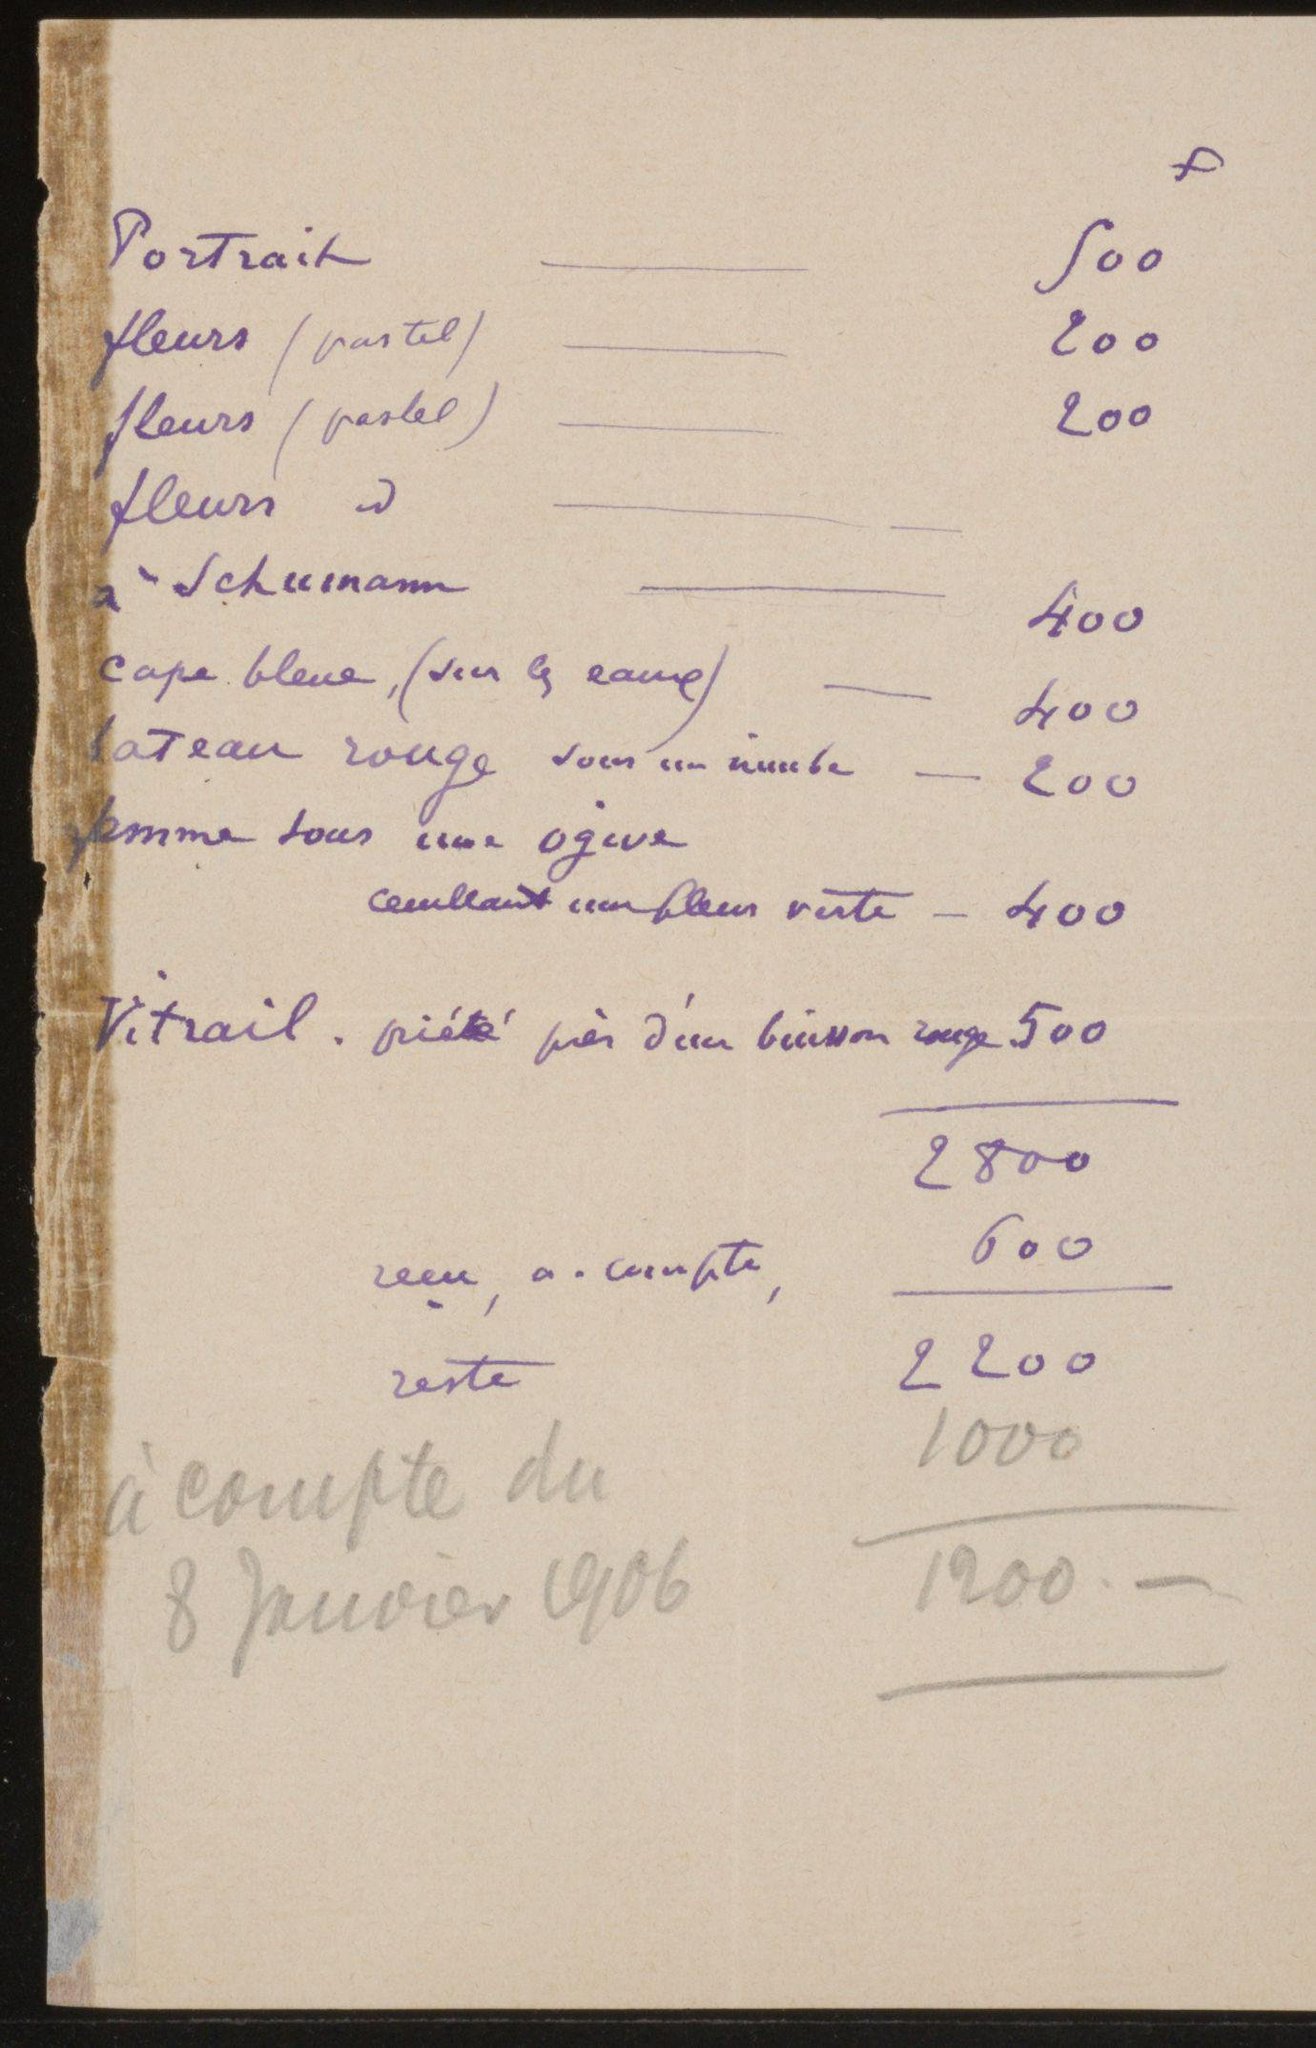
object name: account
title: Rekening aan Andries Bonger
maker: odilon redon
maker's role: draughtsman, painter, print maker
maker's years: 1840-1916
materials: ink, paper, pencil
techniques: pen, writing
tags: andries bonger, money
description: Rekening behoort tot een album samengesteld door weduwe Françoise W.M. Barones van der Borch van Verwolde met afschriften van brieven met betrekking tot (de familie van) Odilon Redon. De rekening werd bewaard op pagina 126. Het betreft kunstwerken die door Odilon Redon aan Andries Bonger zijn verkocht.